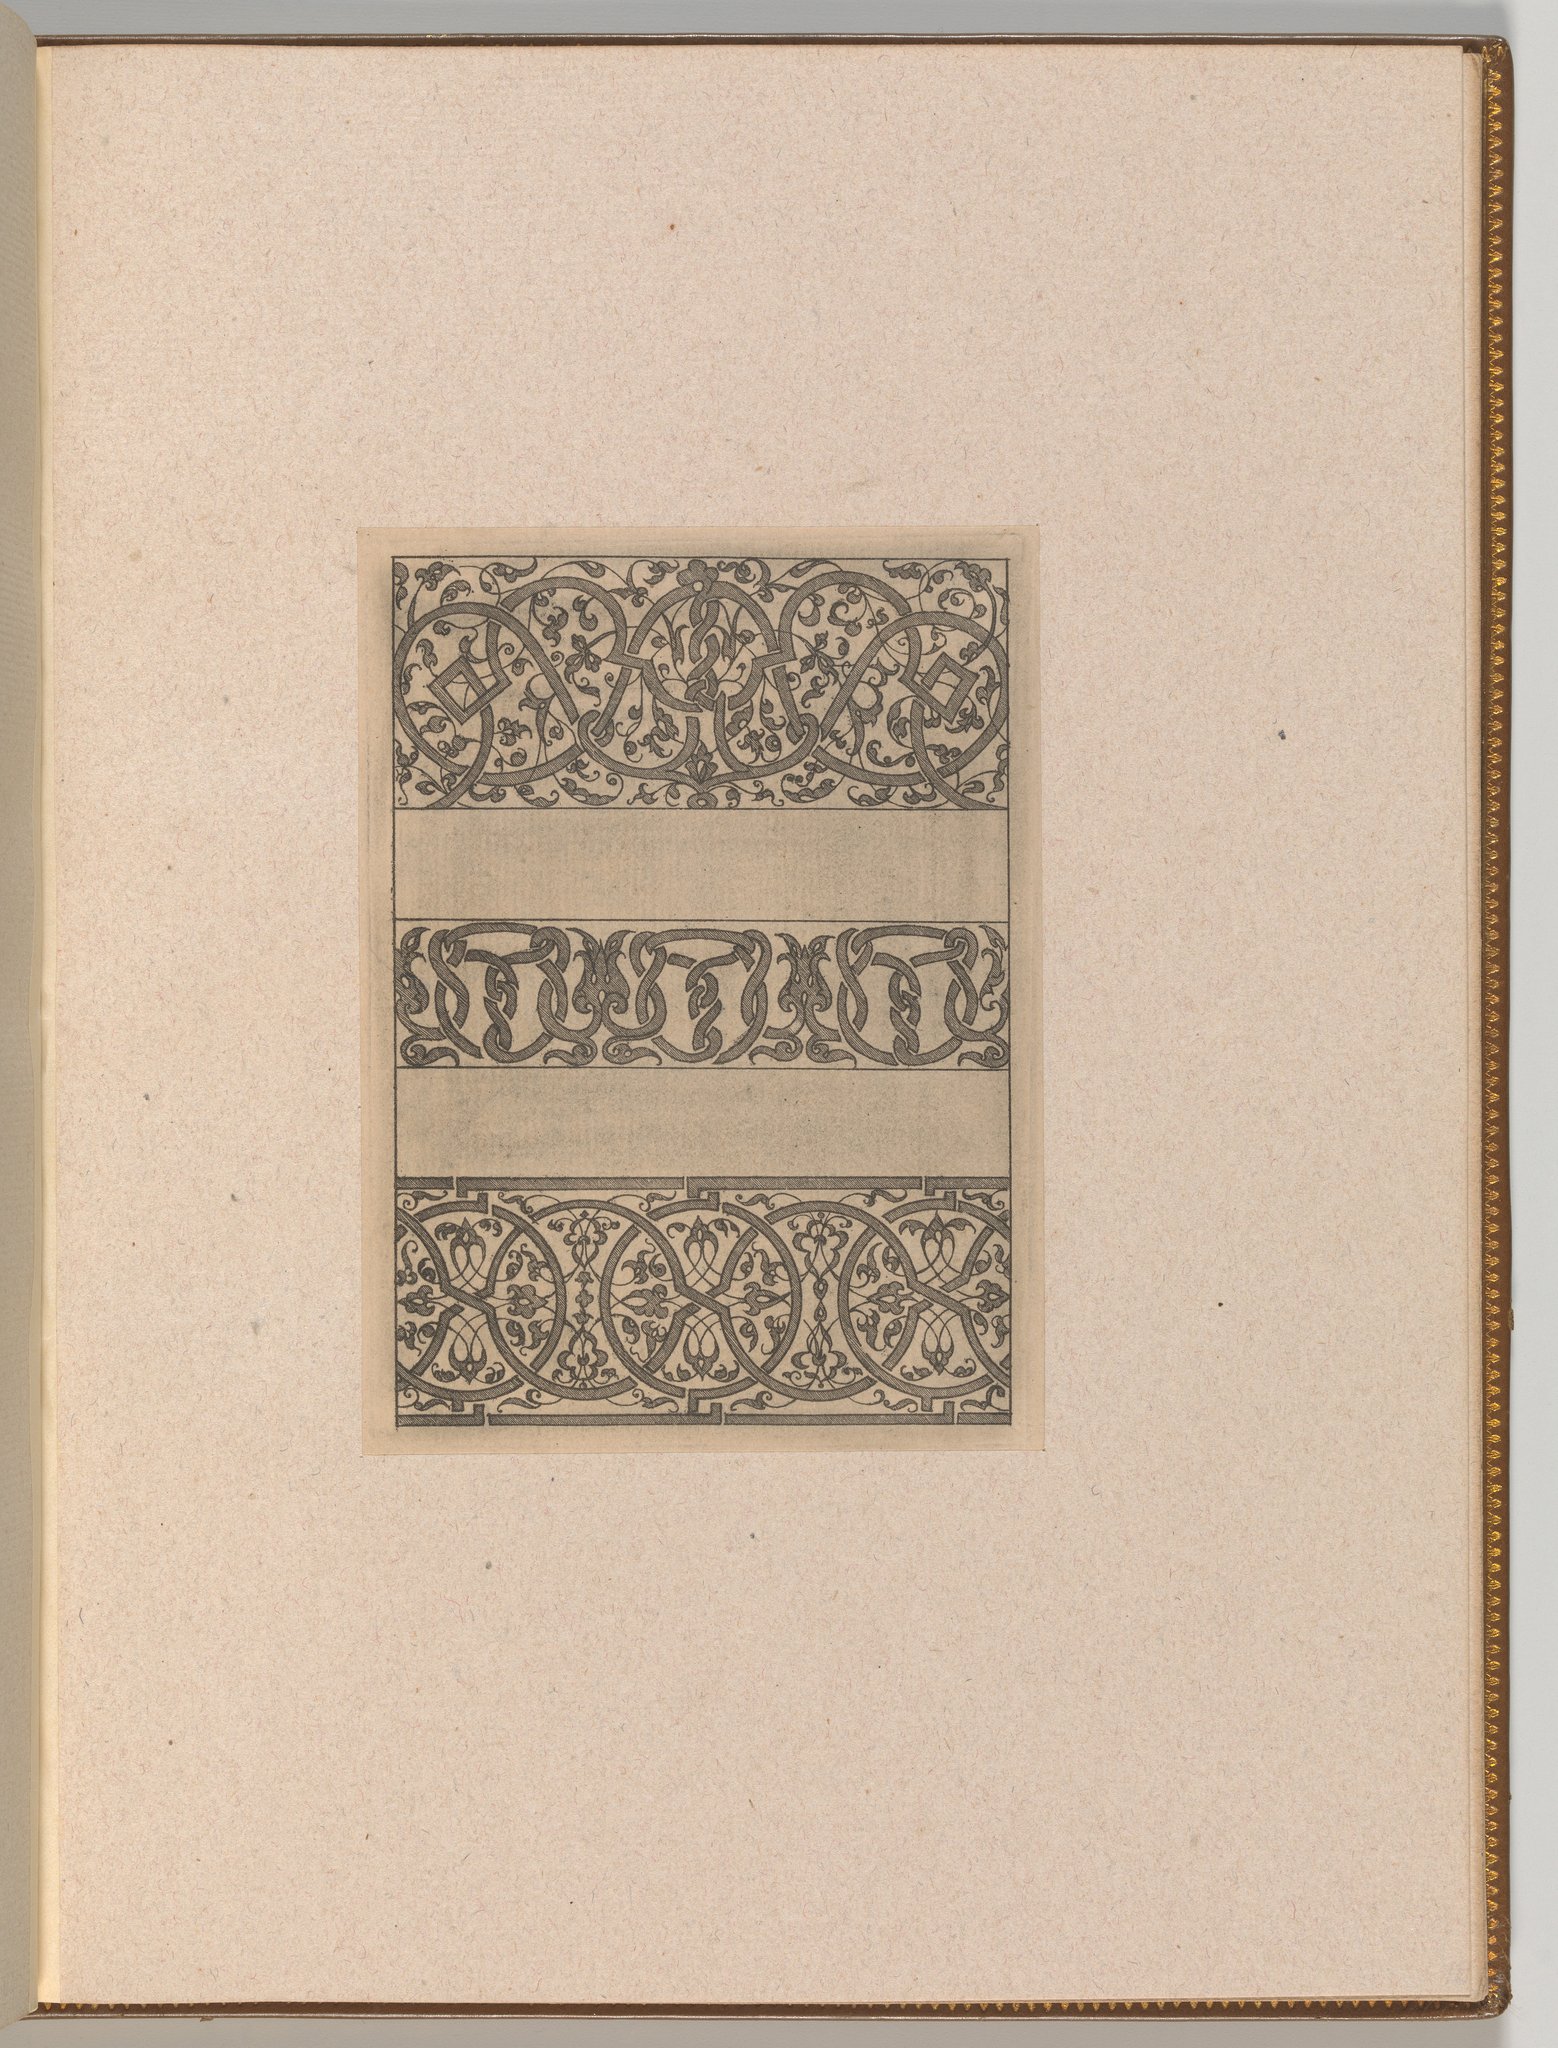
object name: album print ornament architecture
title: Copies after the 'Livre contenant passement de moresques' (plate 18)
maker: jacques androuet du cerceau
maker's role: artist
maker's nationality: french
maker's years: 1510-1585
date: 1801-1900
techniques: etching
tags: ornament